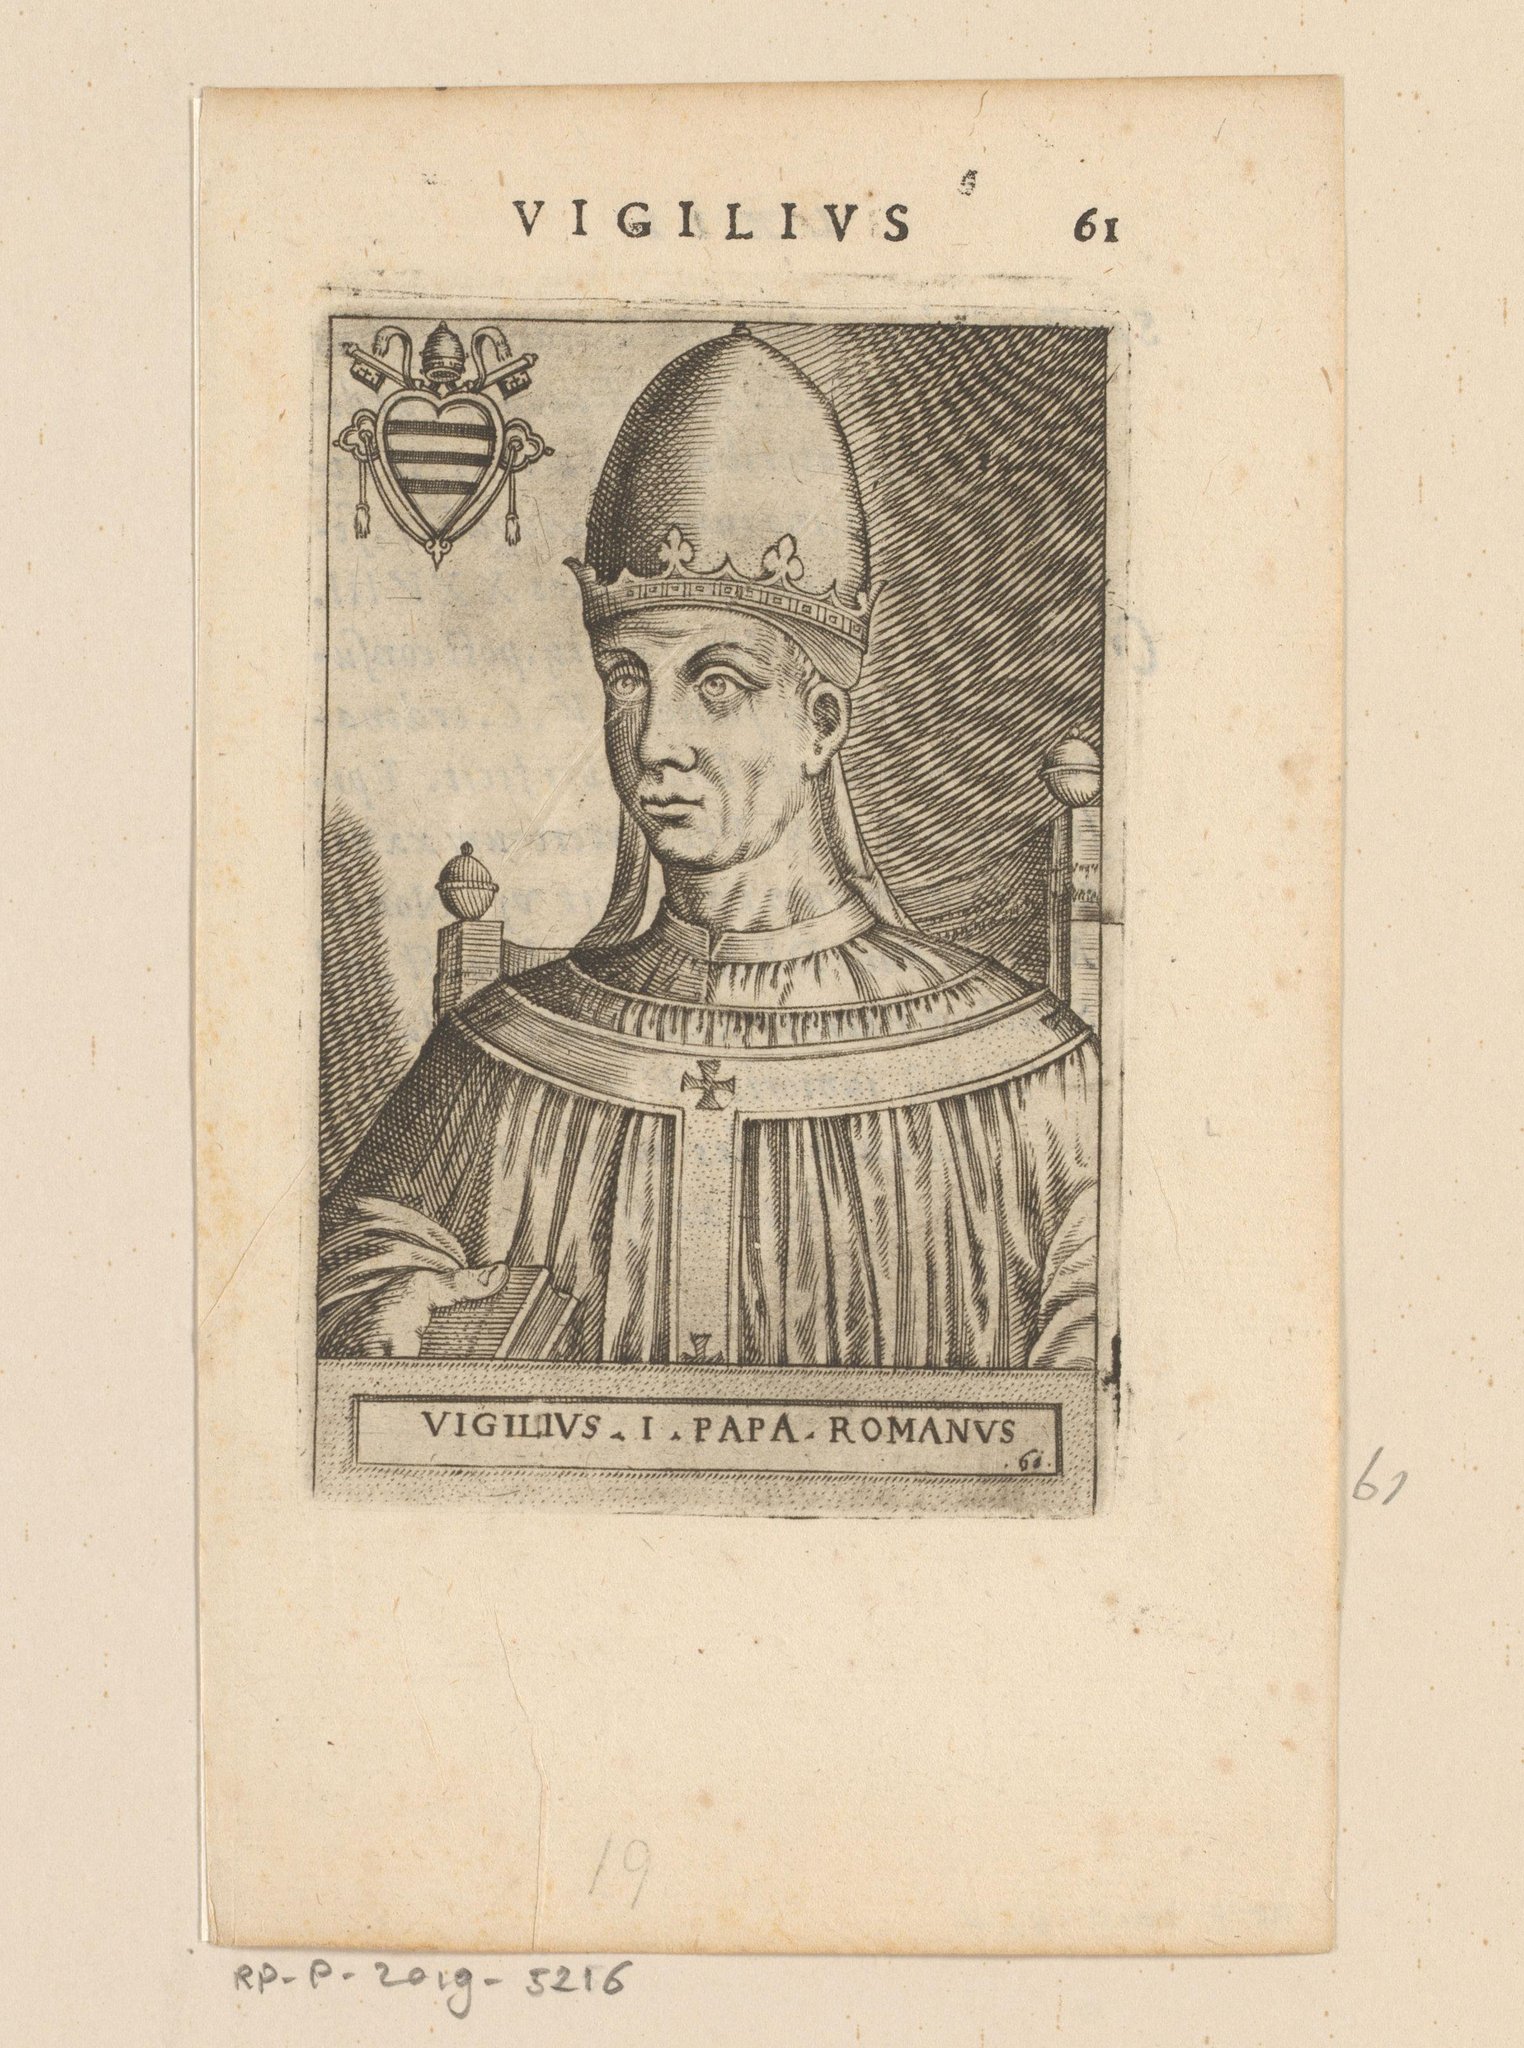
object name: book illustration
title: Portret van paus Vigilius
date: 1595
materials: paper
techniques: engraving, letterpress printing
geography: rome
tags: historical persons, pope, armorial bearing, heraldry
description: Prent uit: Cavalieri, Giovanni Battista de'. Effigies pontificum romanorum cum eorum vitis (...). Rome: Bartolomeo Bonfadino, 1595. Prent voor het eerst verschenen in: Cavalieri, Giovanni Battista de'. Pontificum romanorum effigies (...). Rome: Domenico Basa en Francesco Zanetti, 1580. Prent ook gebruikt in latere publicaties.